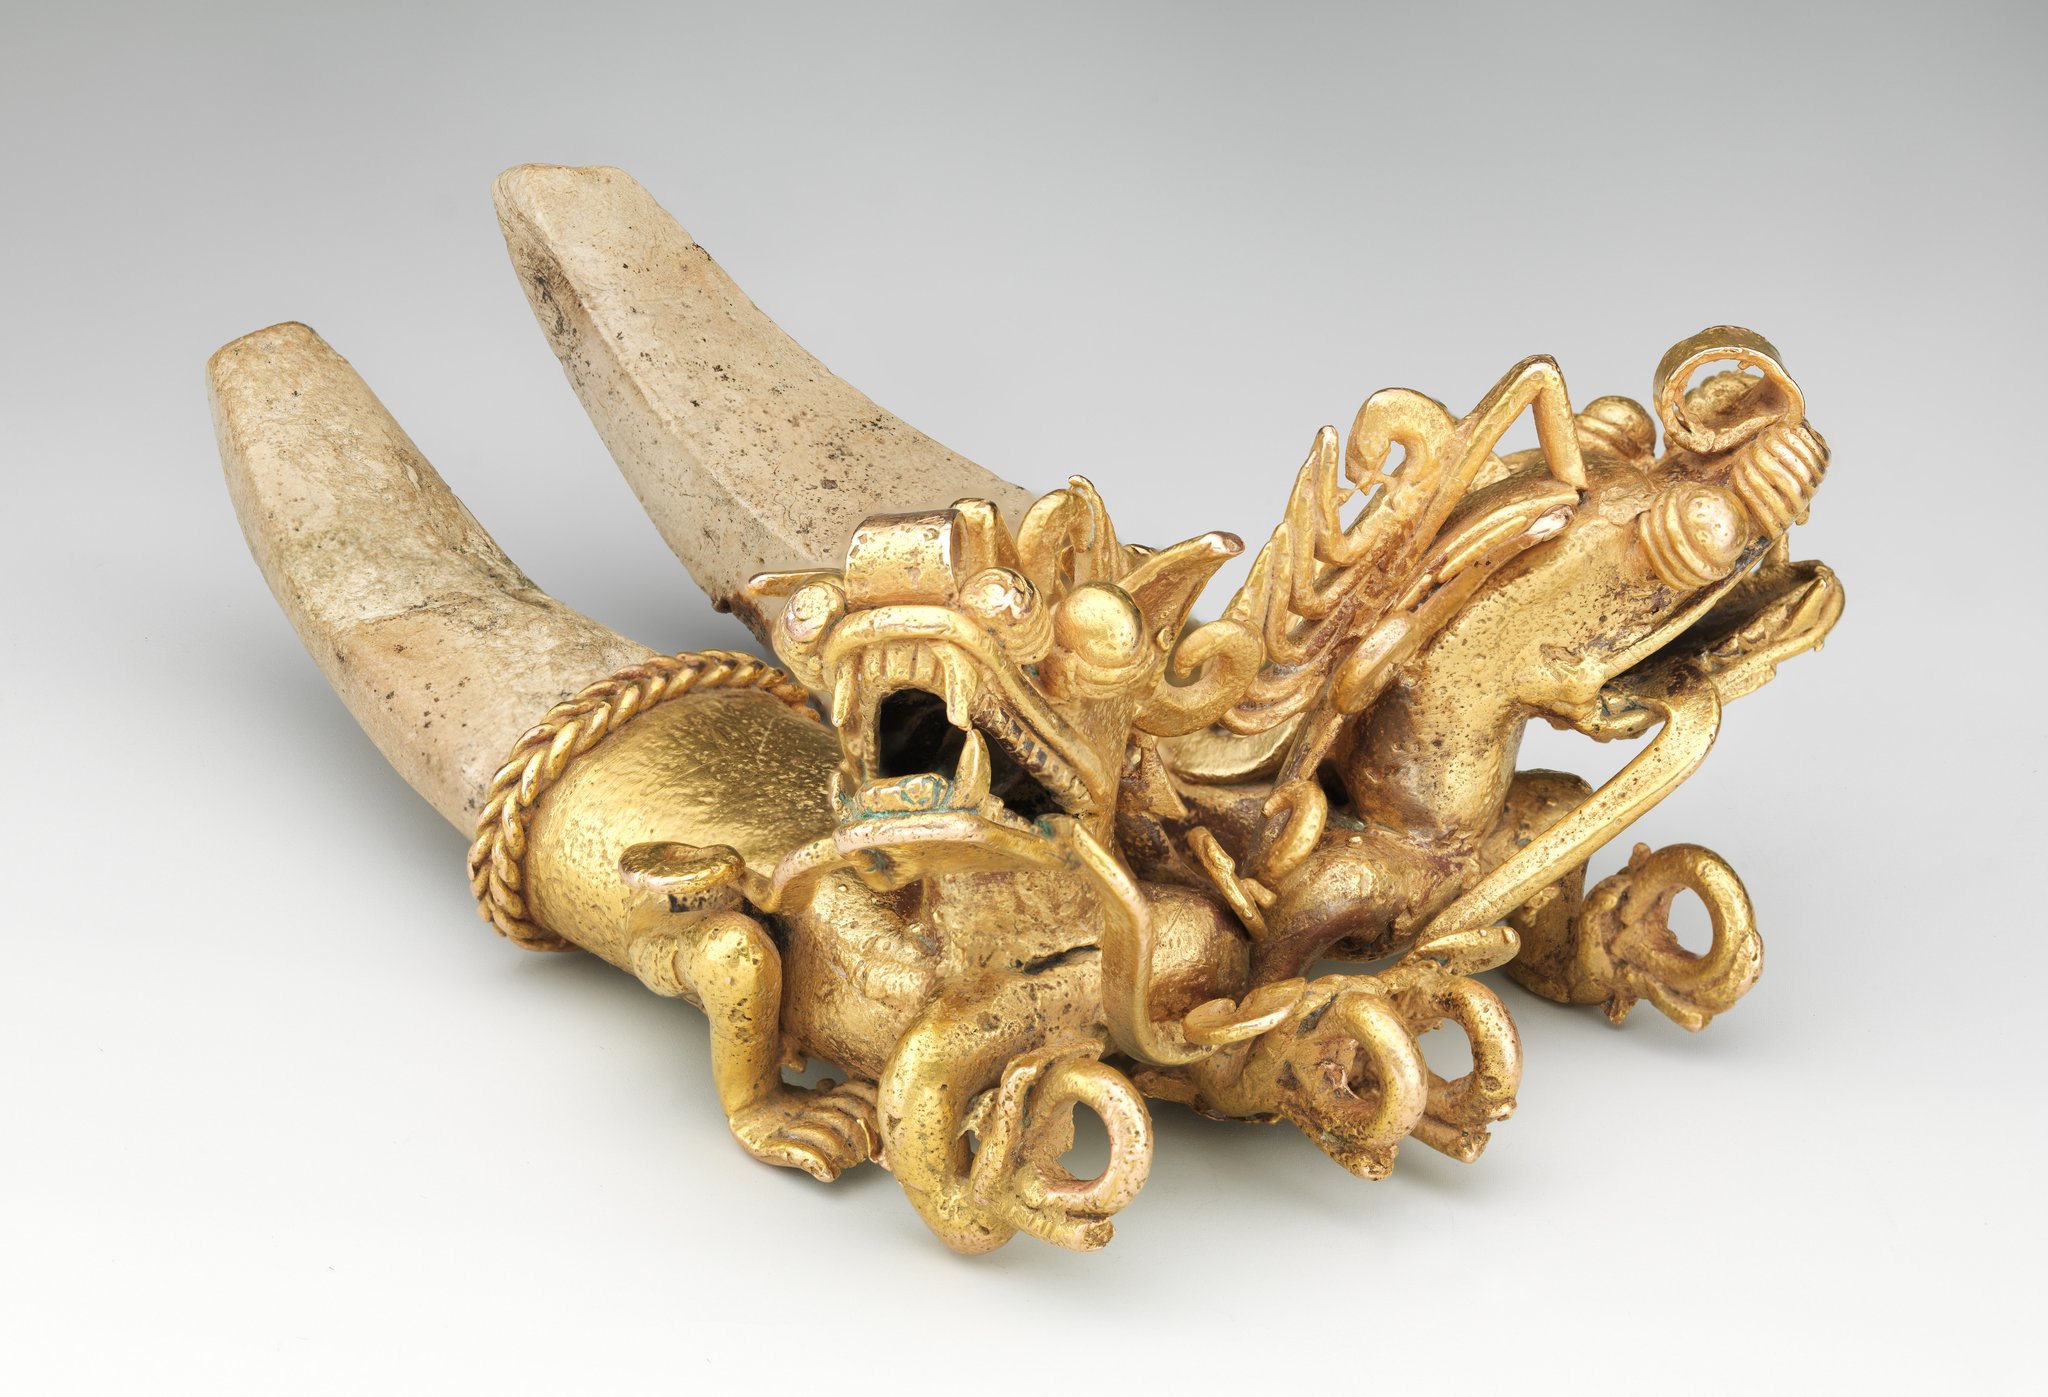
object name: pendant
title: Double crocodile pendant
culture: coclé, macaracas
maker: coclé (macaracas) artist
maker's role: artist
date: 950-1100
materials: gold, shell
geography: panama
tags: crocodiles